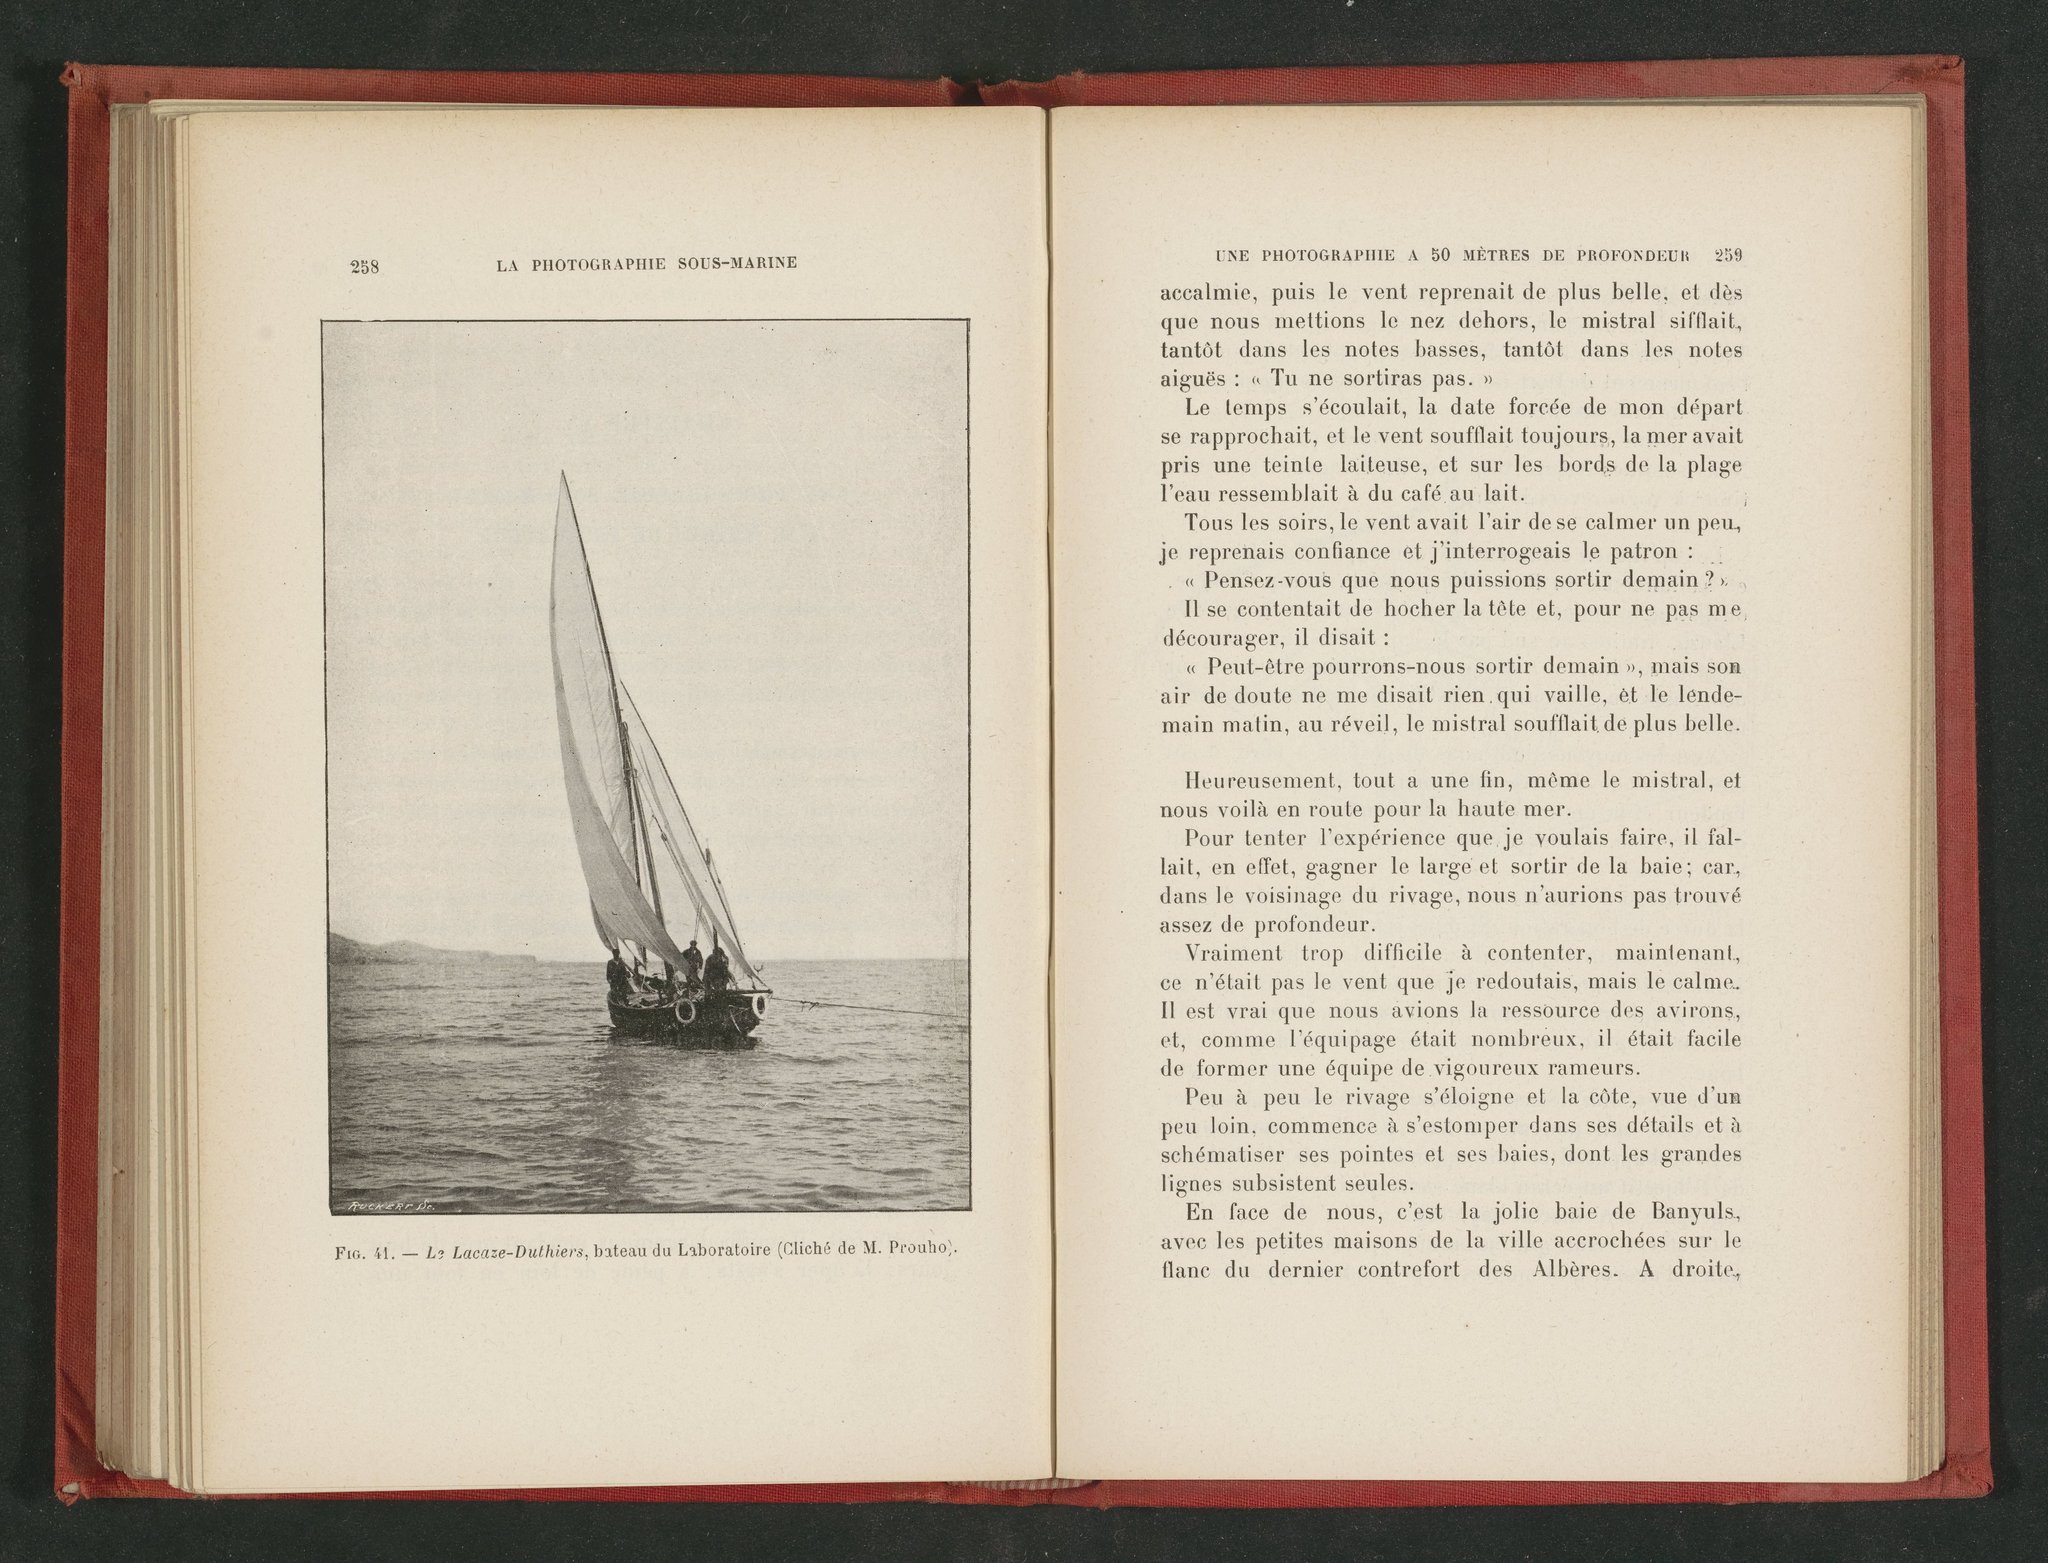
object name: photomechanical print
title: Gezicht op de boot Lacaze-Duthiers van het Laboratoire Arago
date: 1890-1900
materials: paper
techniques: autotype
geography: france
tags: ships (in general)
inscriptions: number: ‘Fig. 41.’